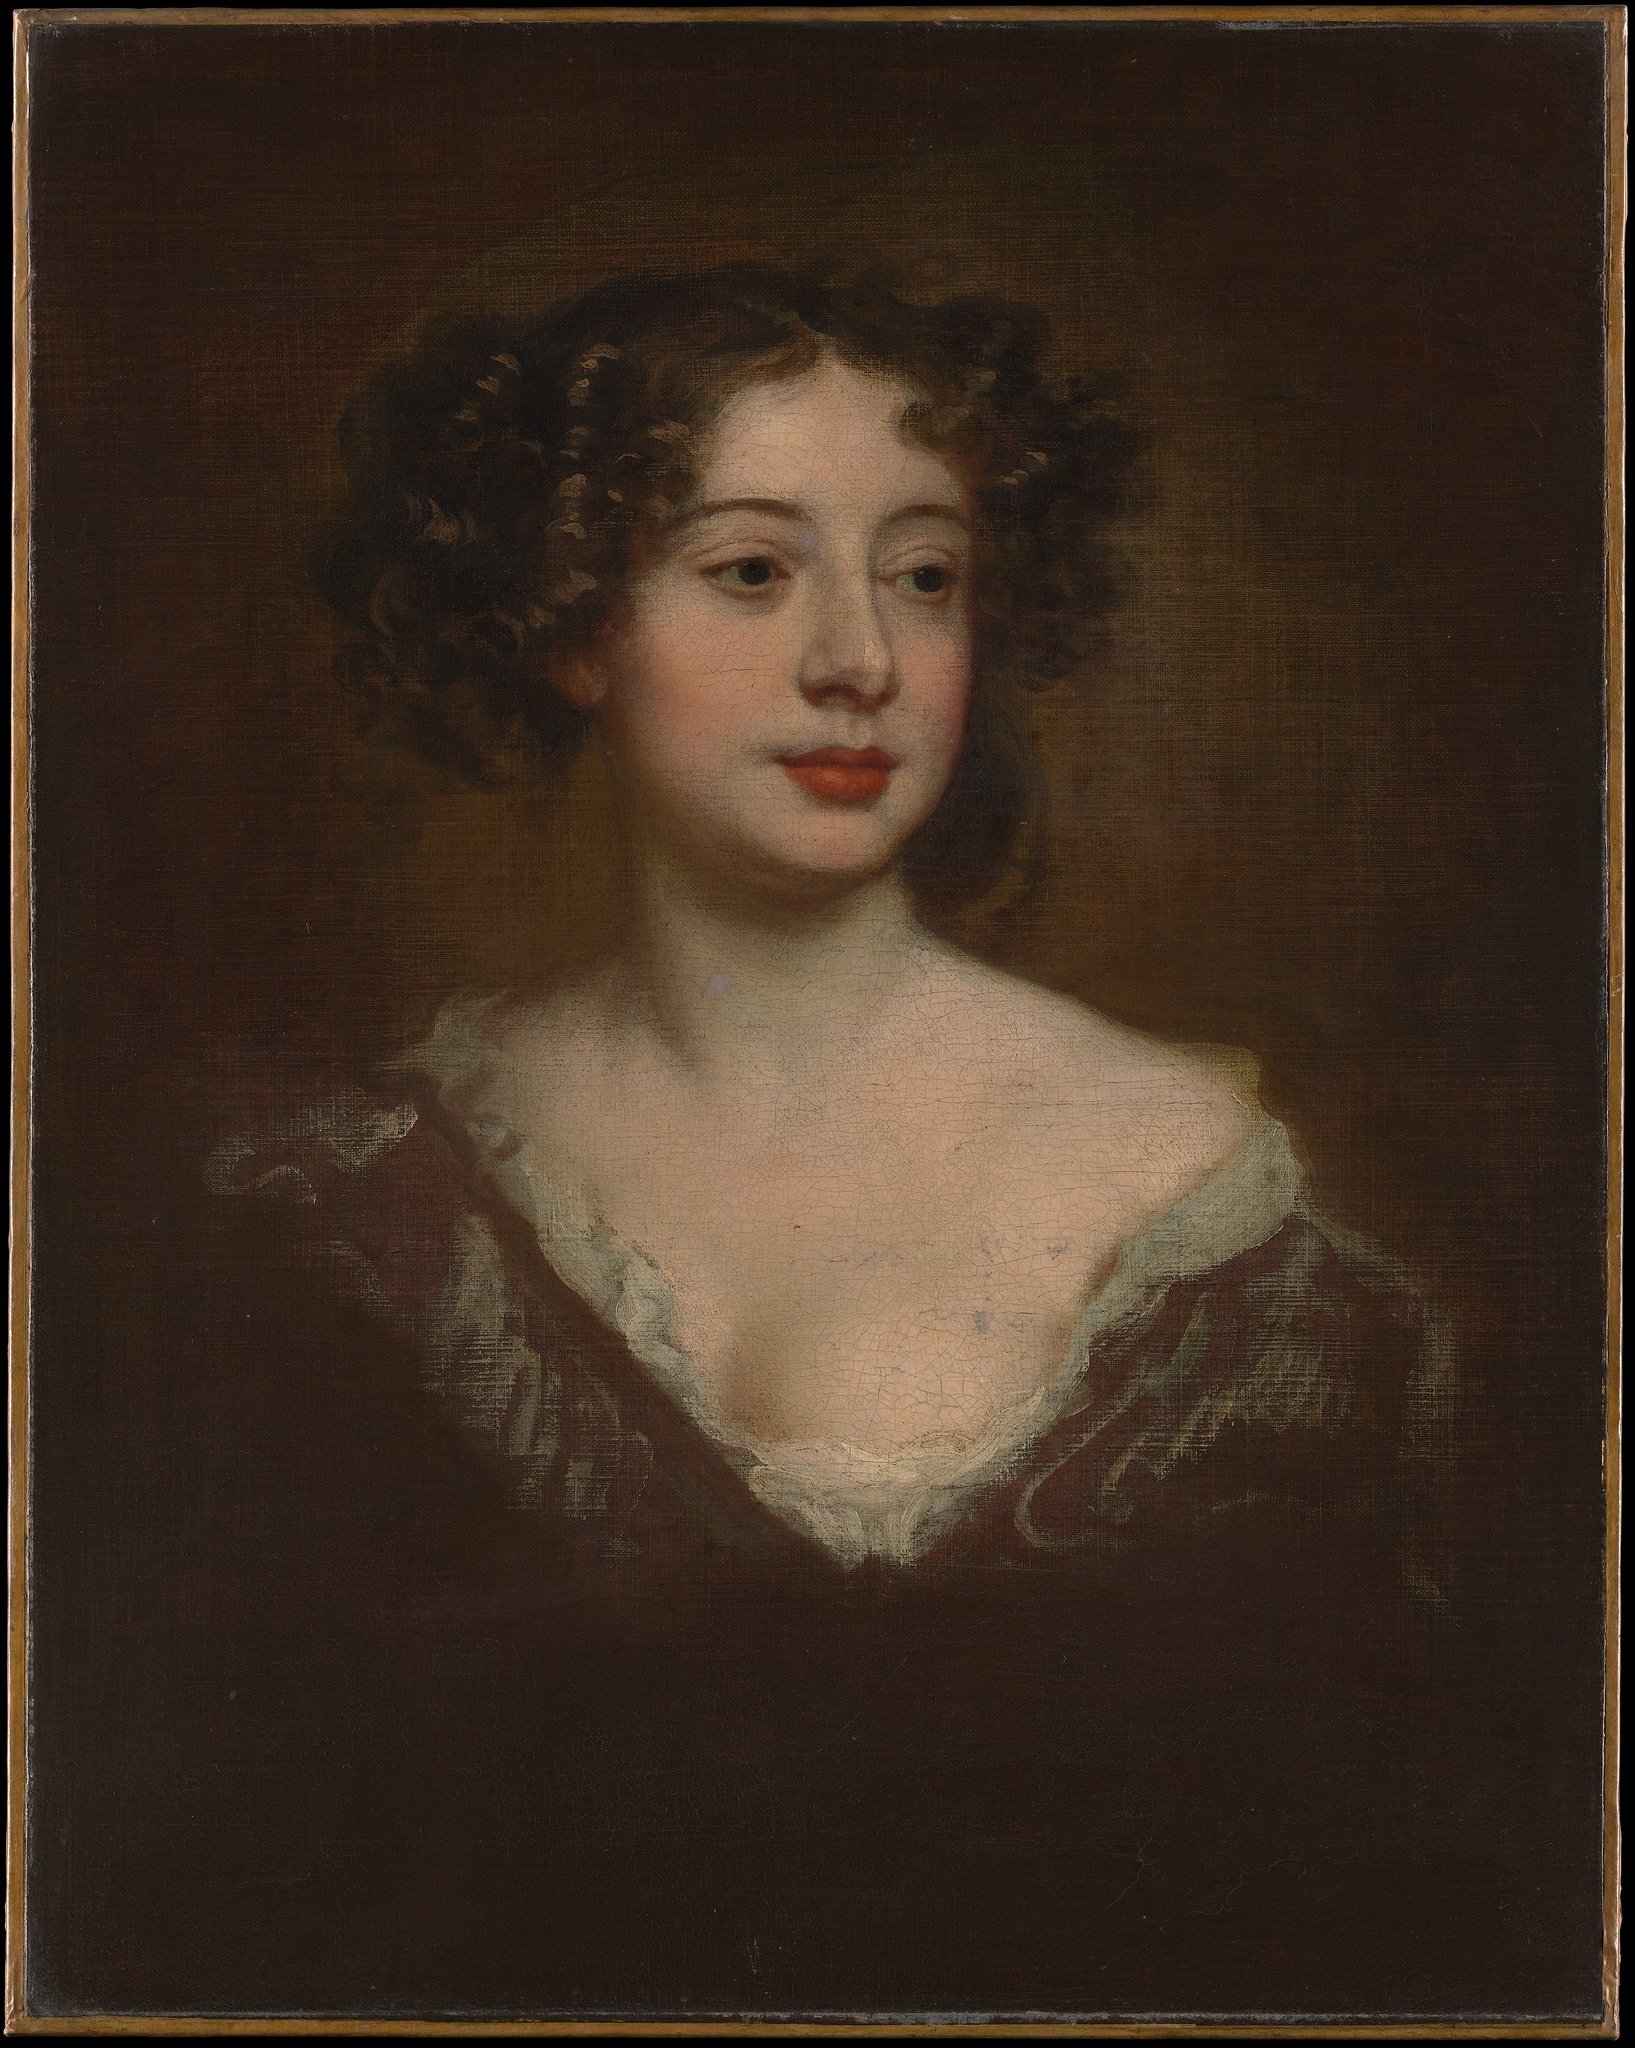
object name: painting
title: Study for a Portrait of a Woman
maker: peter lely (sir)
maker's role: artist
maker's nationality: dutch, british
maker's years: 1618-1680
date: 1670-1679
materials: canvas, oil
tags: portraits,women